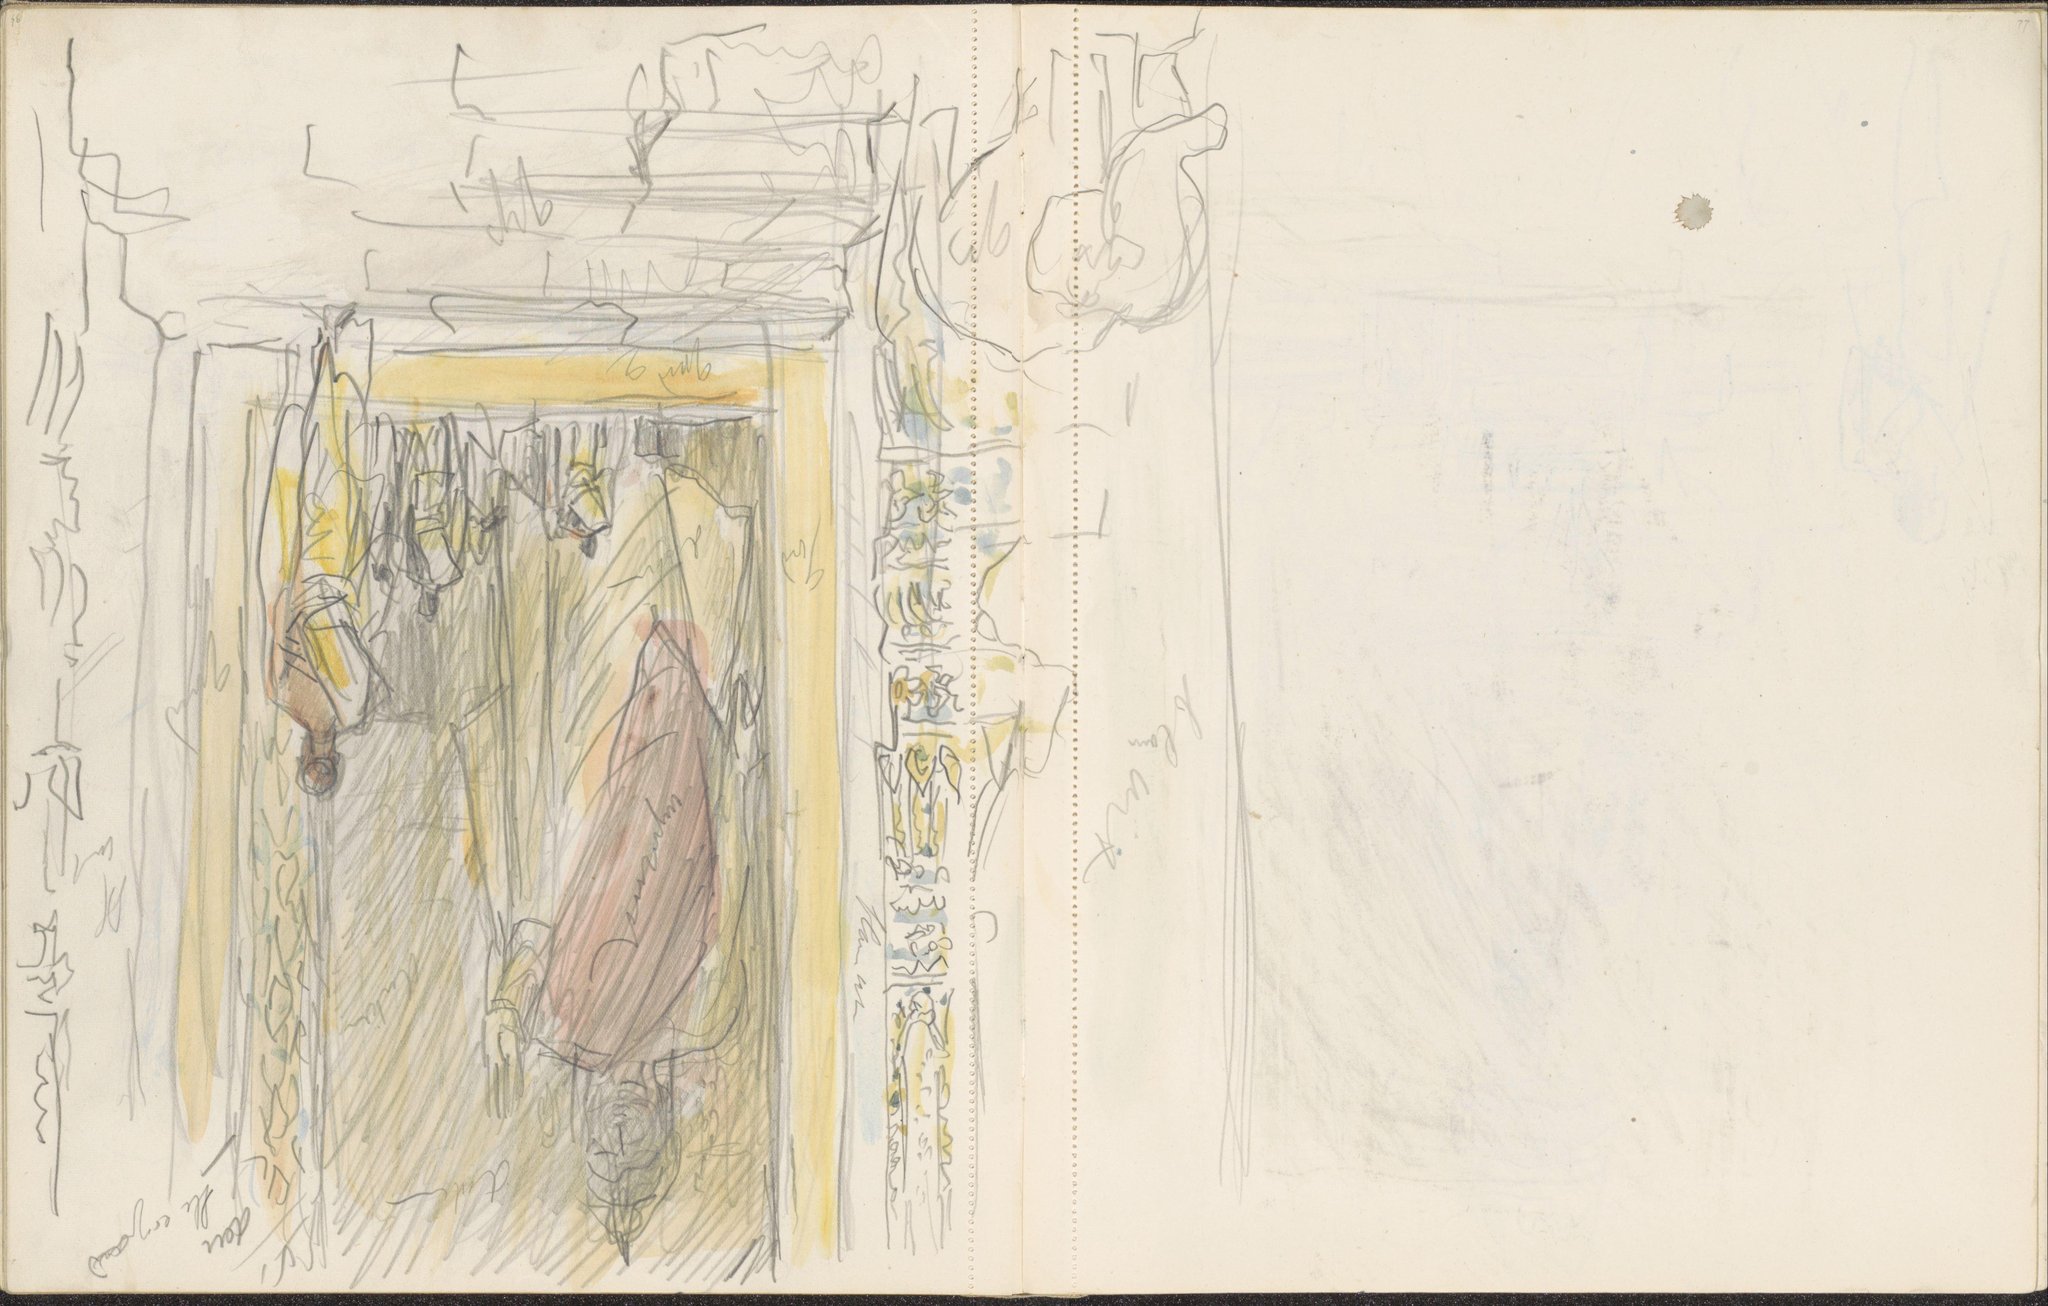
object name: sketchbook leaf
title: Monniken bij de ingang van een tempel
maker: marius bauer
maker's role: draughtsman, print maker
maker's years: 1867-1932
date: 1931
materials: paper, pencil, watercolor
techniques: brush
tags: temple, shrine ~ hinduism, buddhism, jainism, flight of steps, altar ~ hinduism, buddhism, jainism, gate, entrance, religious functionaries ~ hinduism, buddhism, jainism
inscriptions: kleurnotitie, handgeschreven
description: In de tempel staat een godenbeeld. Pagina 76 en 77 uit een schetsboek met 48 bladen.